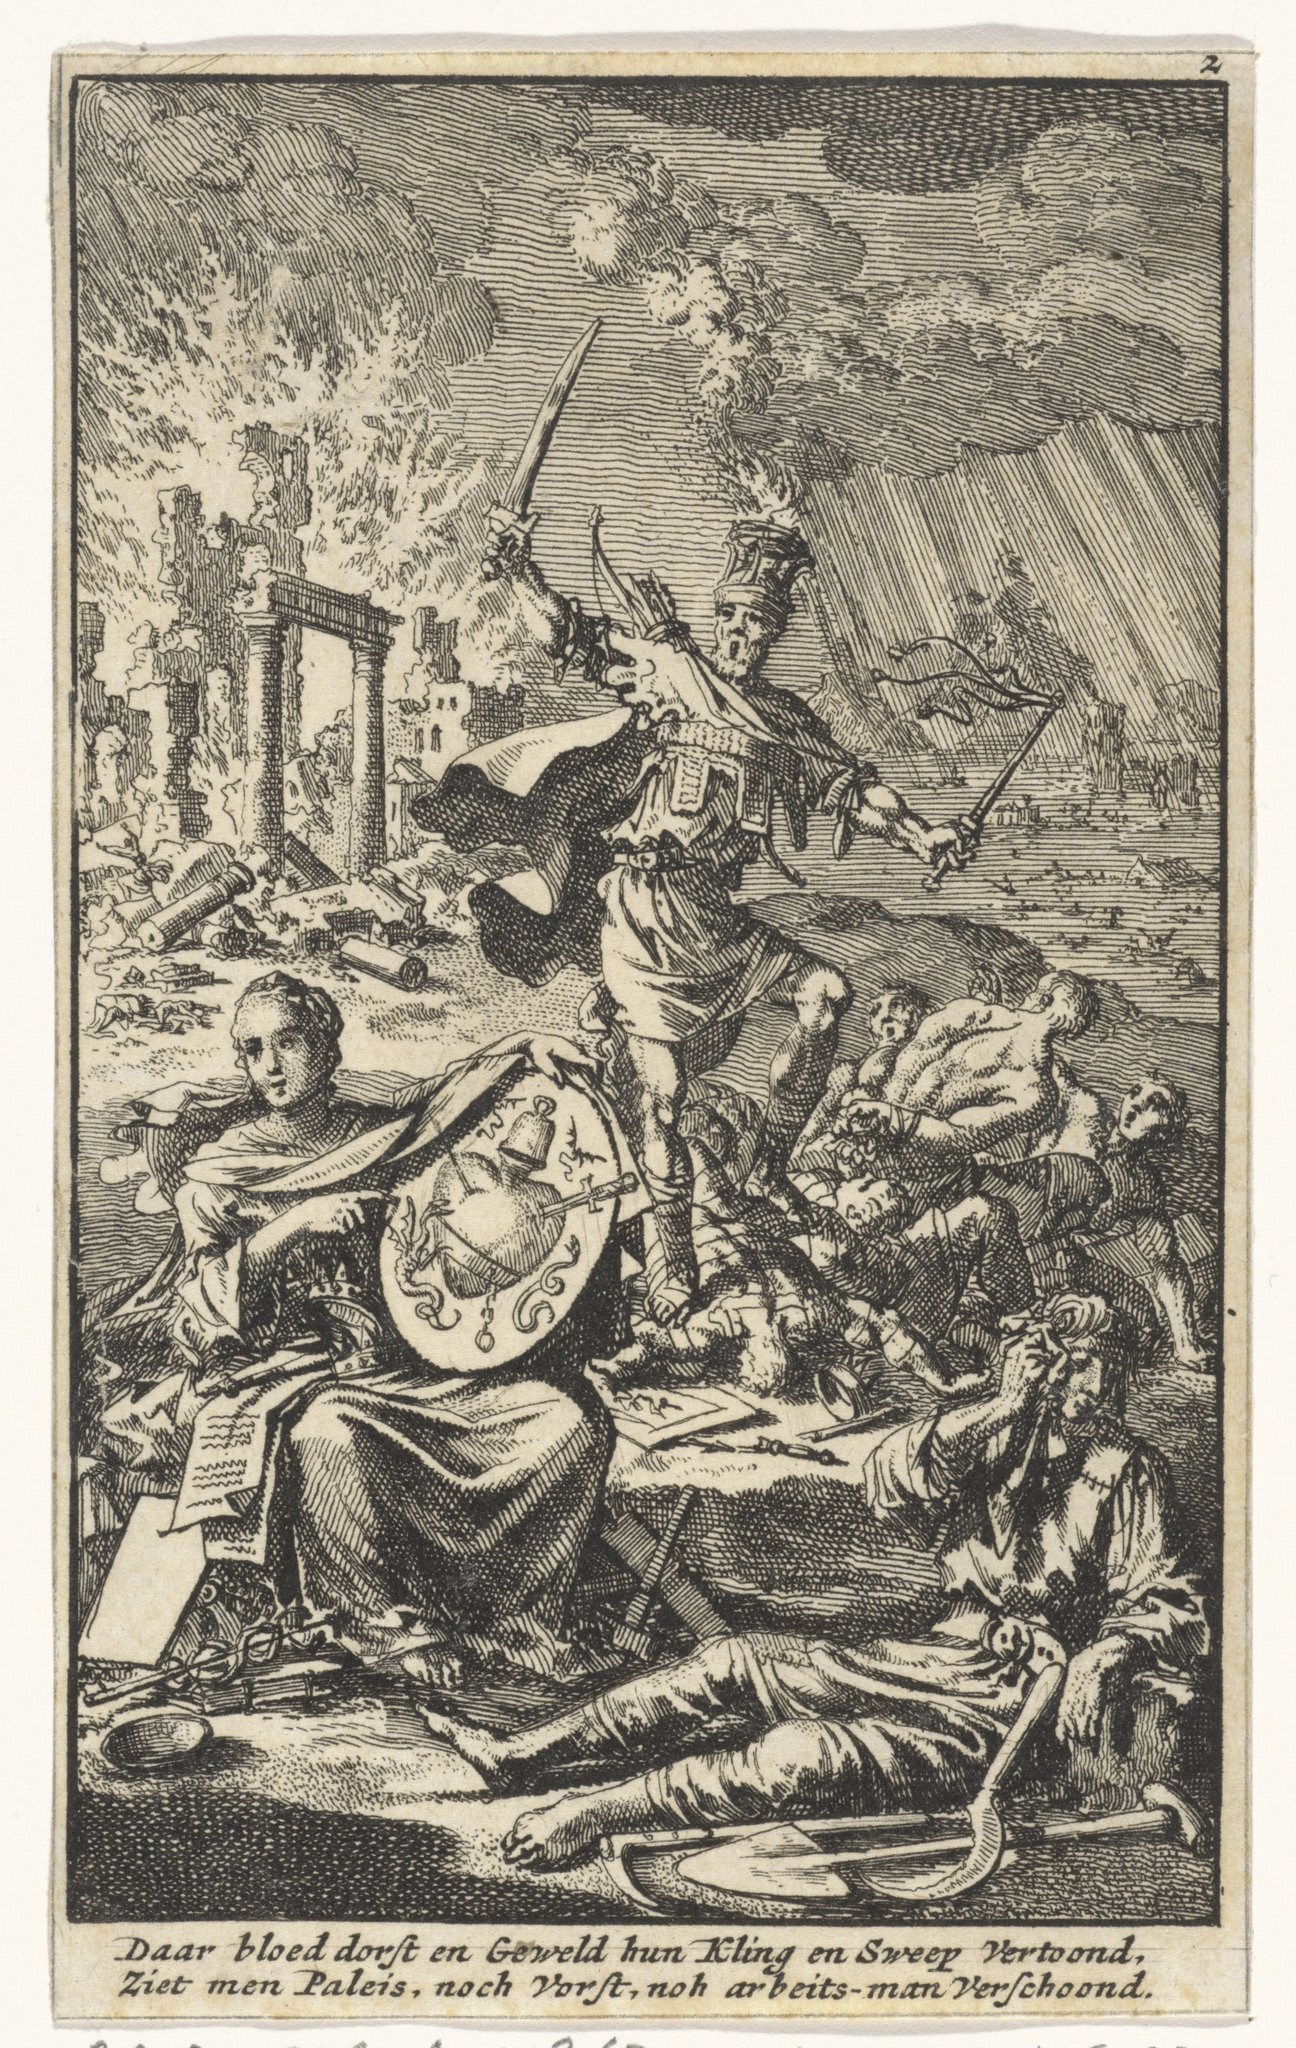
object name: print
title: Geweld vertrapt de overwonnenen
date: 1706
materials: paper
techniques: etching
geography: amsterdam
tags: heart symbolism, the defeated before the victor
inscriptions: collector's mark: Lugt 2228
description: Illustratie voor: Bouman, Herkules. Waereld vol stryd. Amsterdam: Jacob van Royen, 1706.